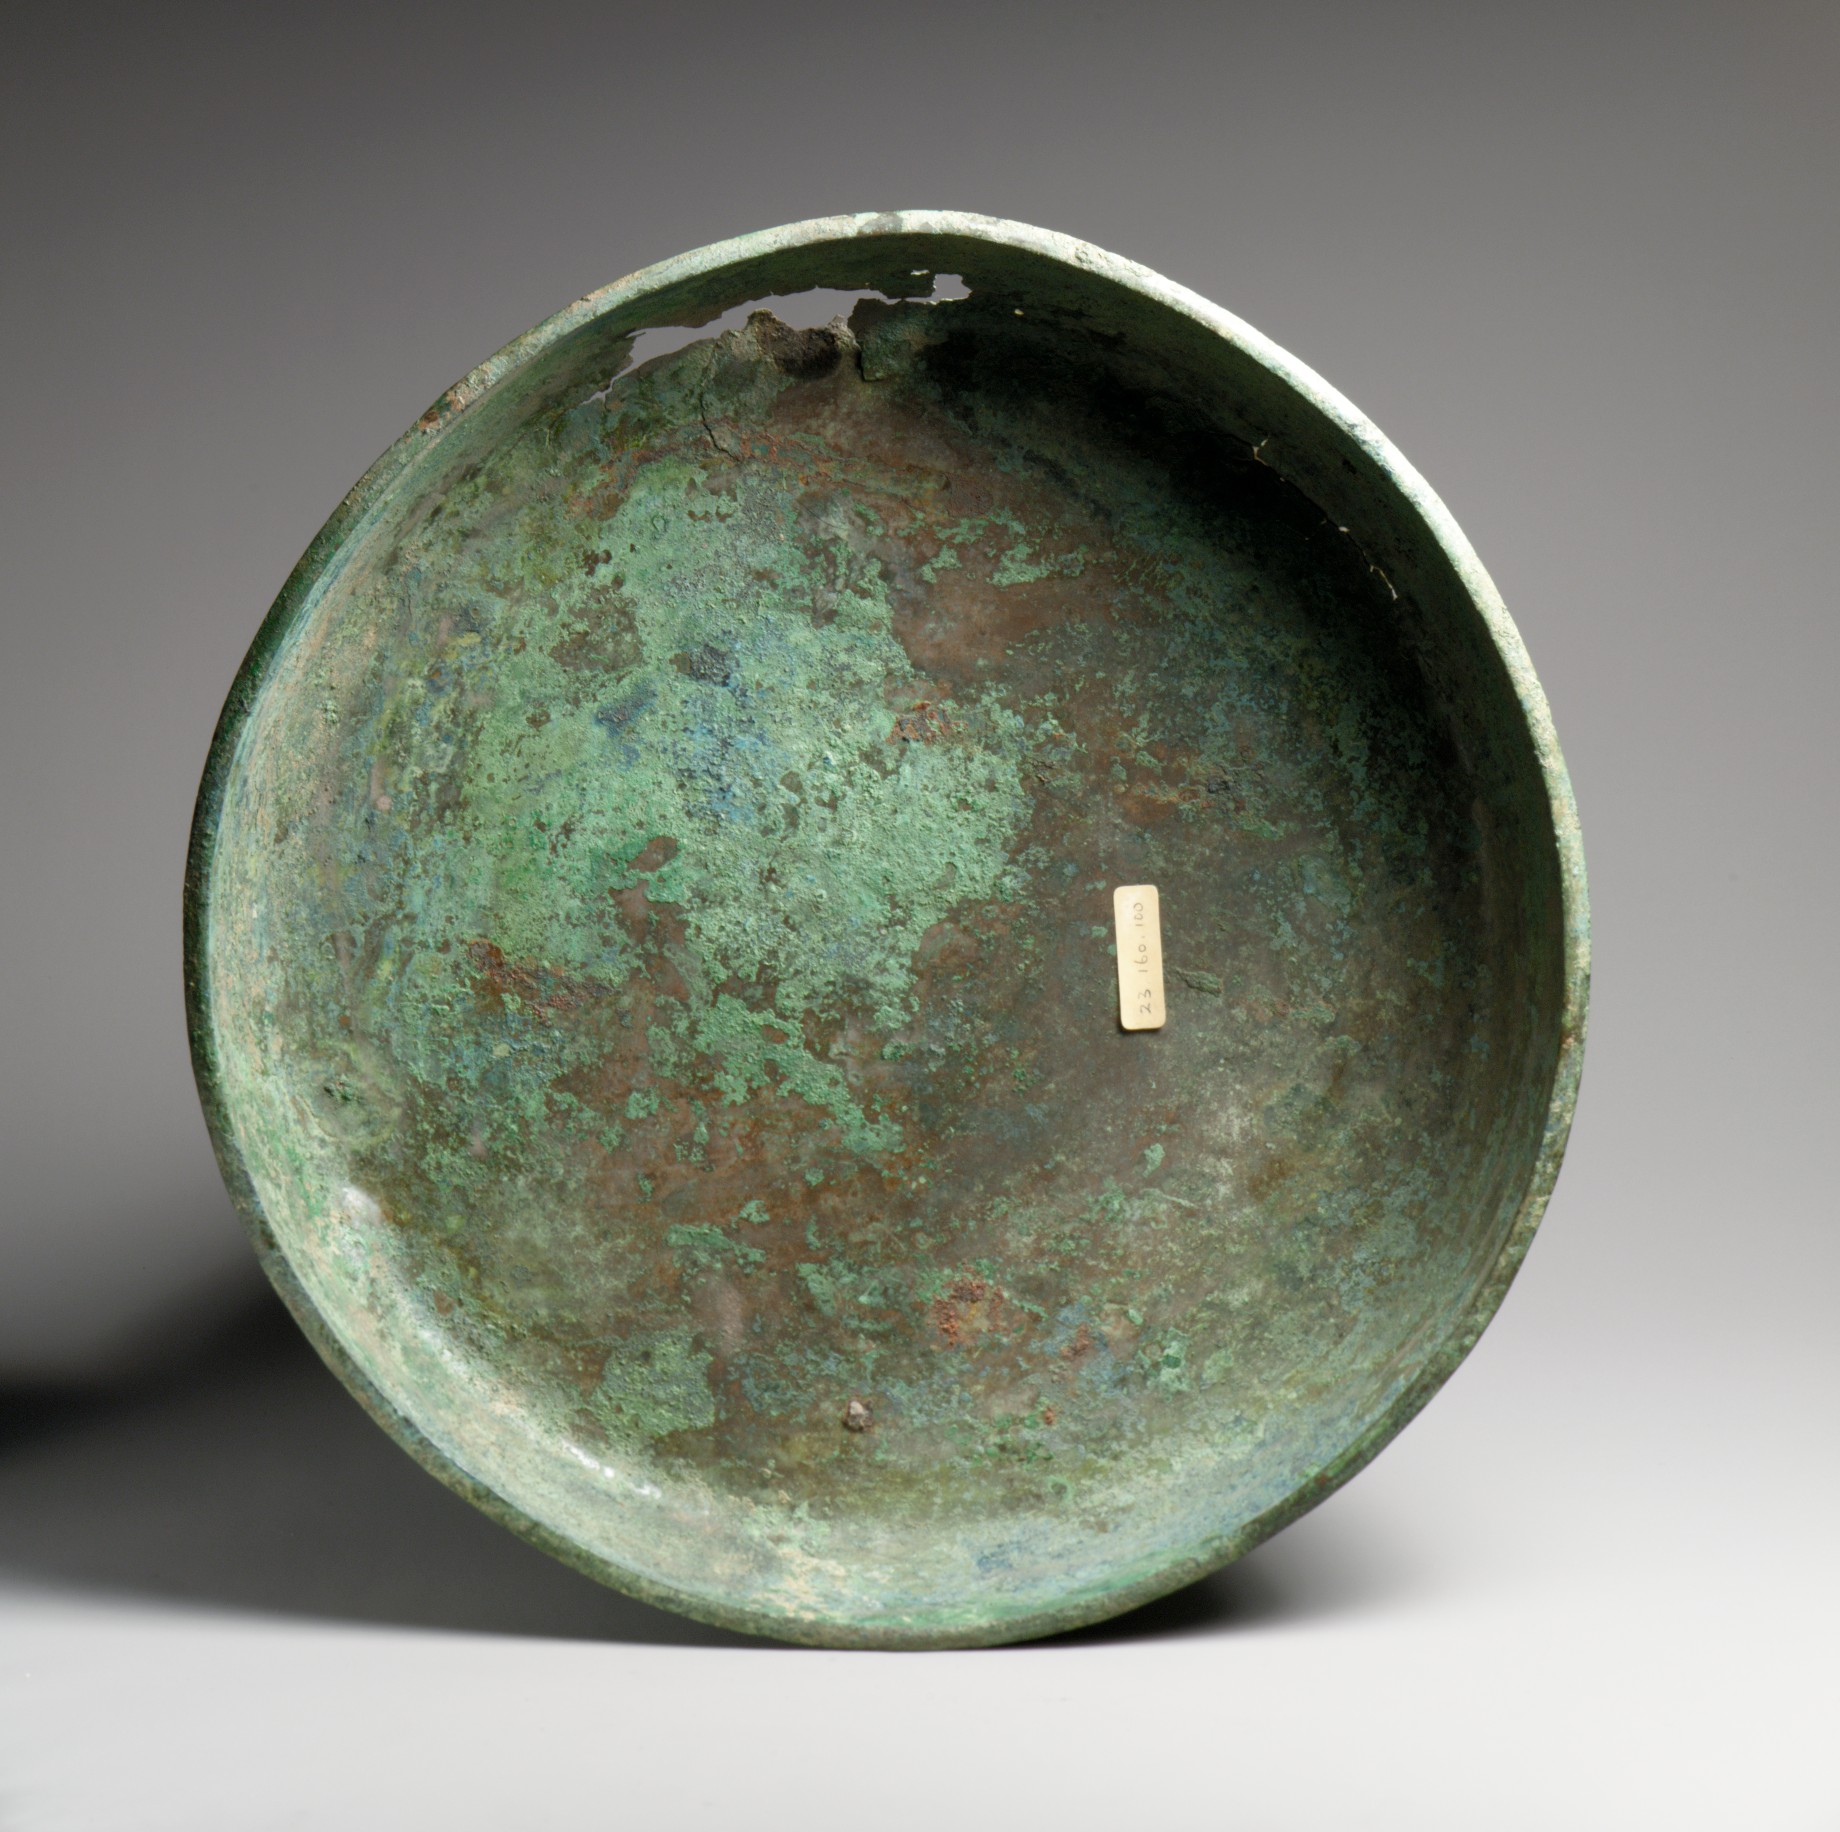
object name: bowl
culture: etruscan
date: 600-401 BCE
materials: bronze